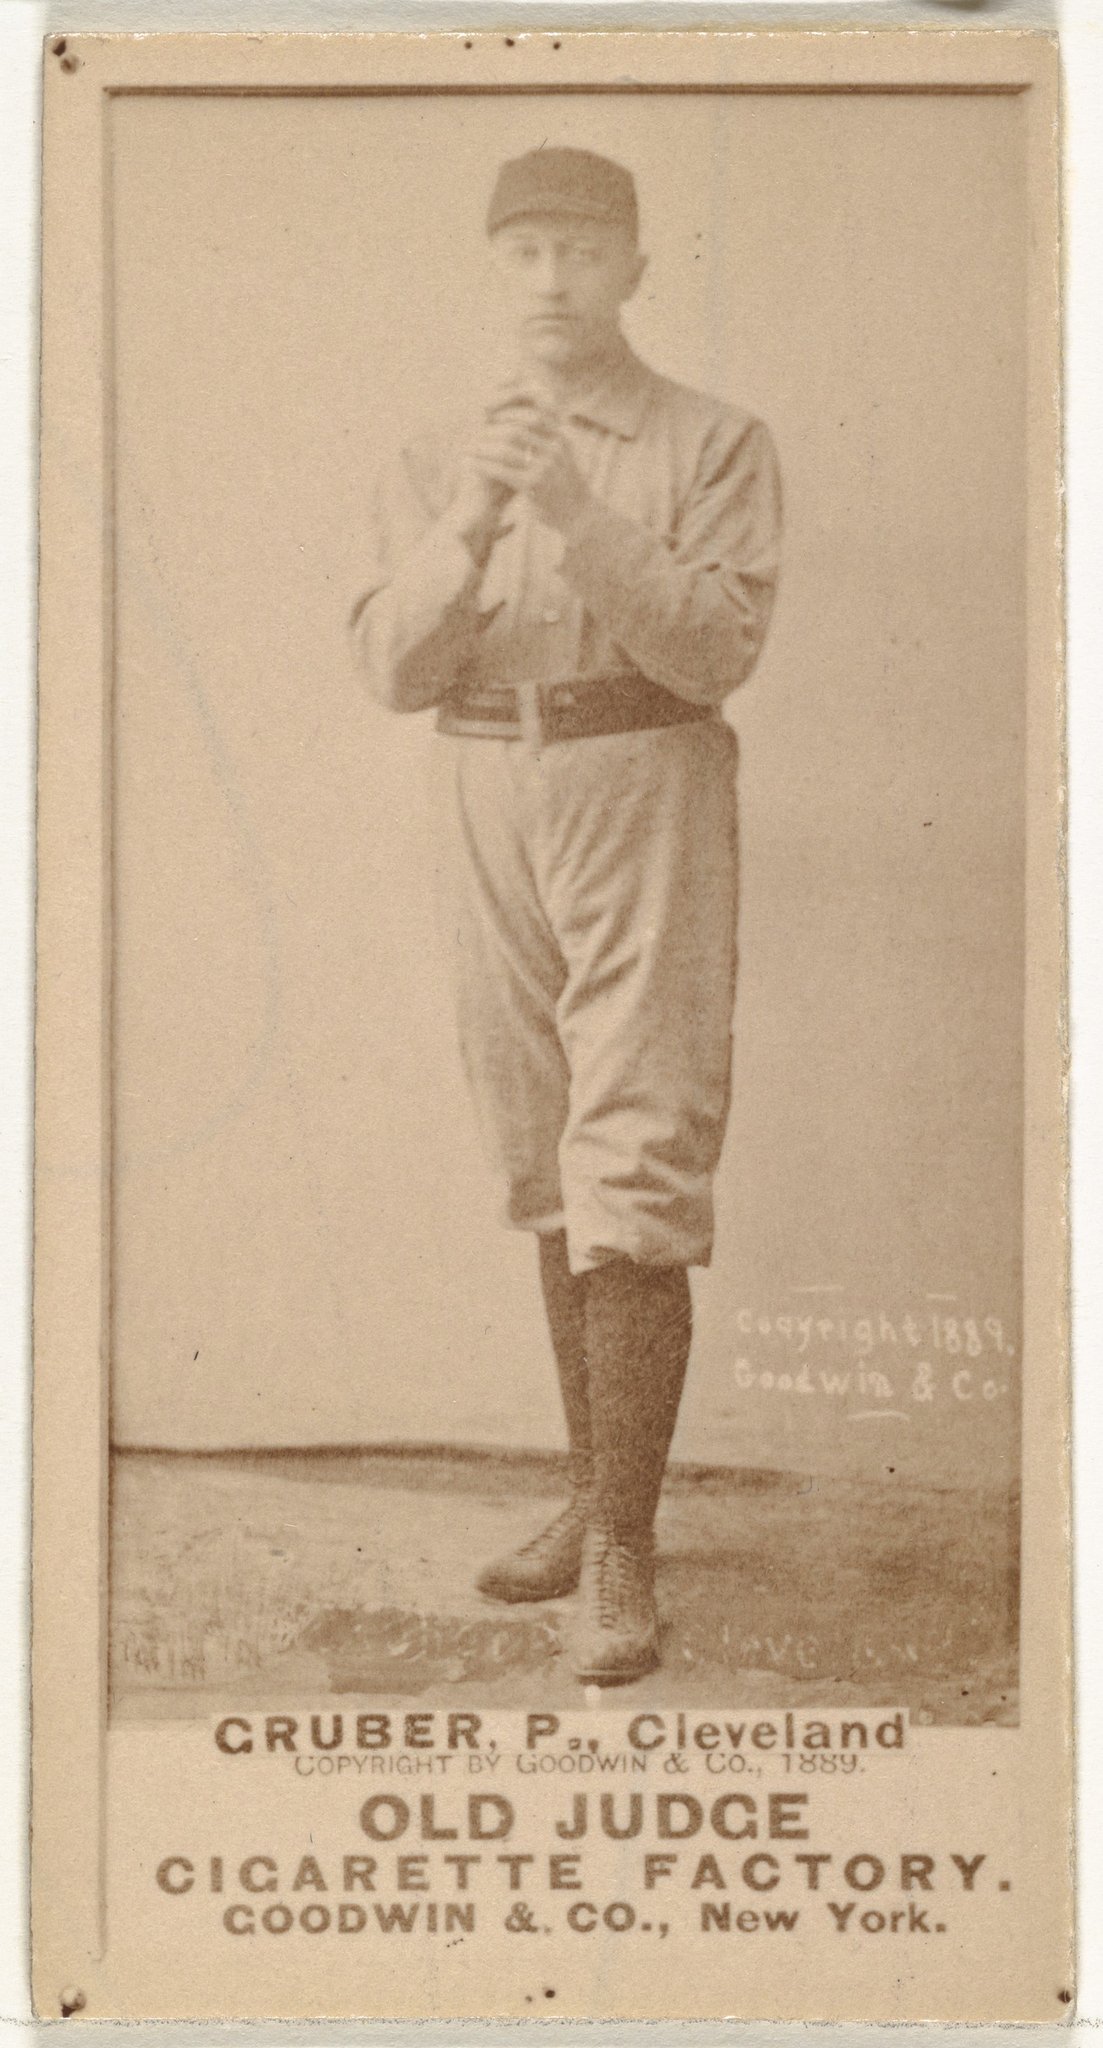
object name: baseball card, photograph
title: Henry Gruber, Pitcher, Cleveland, from the Old Judge series (N172) for Old Judge Cigarettes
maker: goodwin & company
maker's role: publisher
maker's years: 1850-1950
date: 1889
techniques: albumen silver print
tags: men,portraits,baseball,athletes